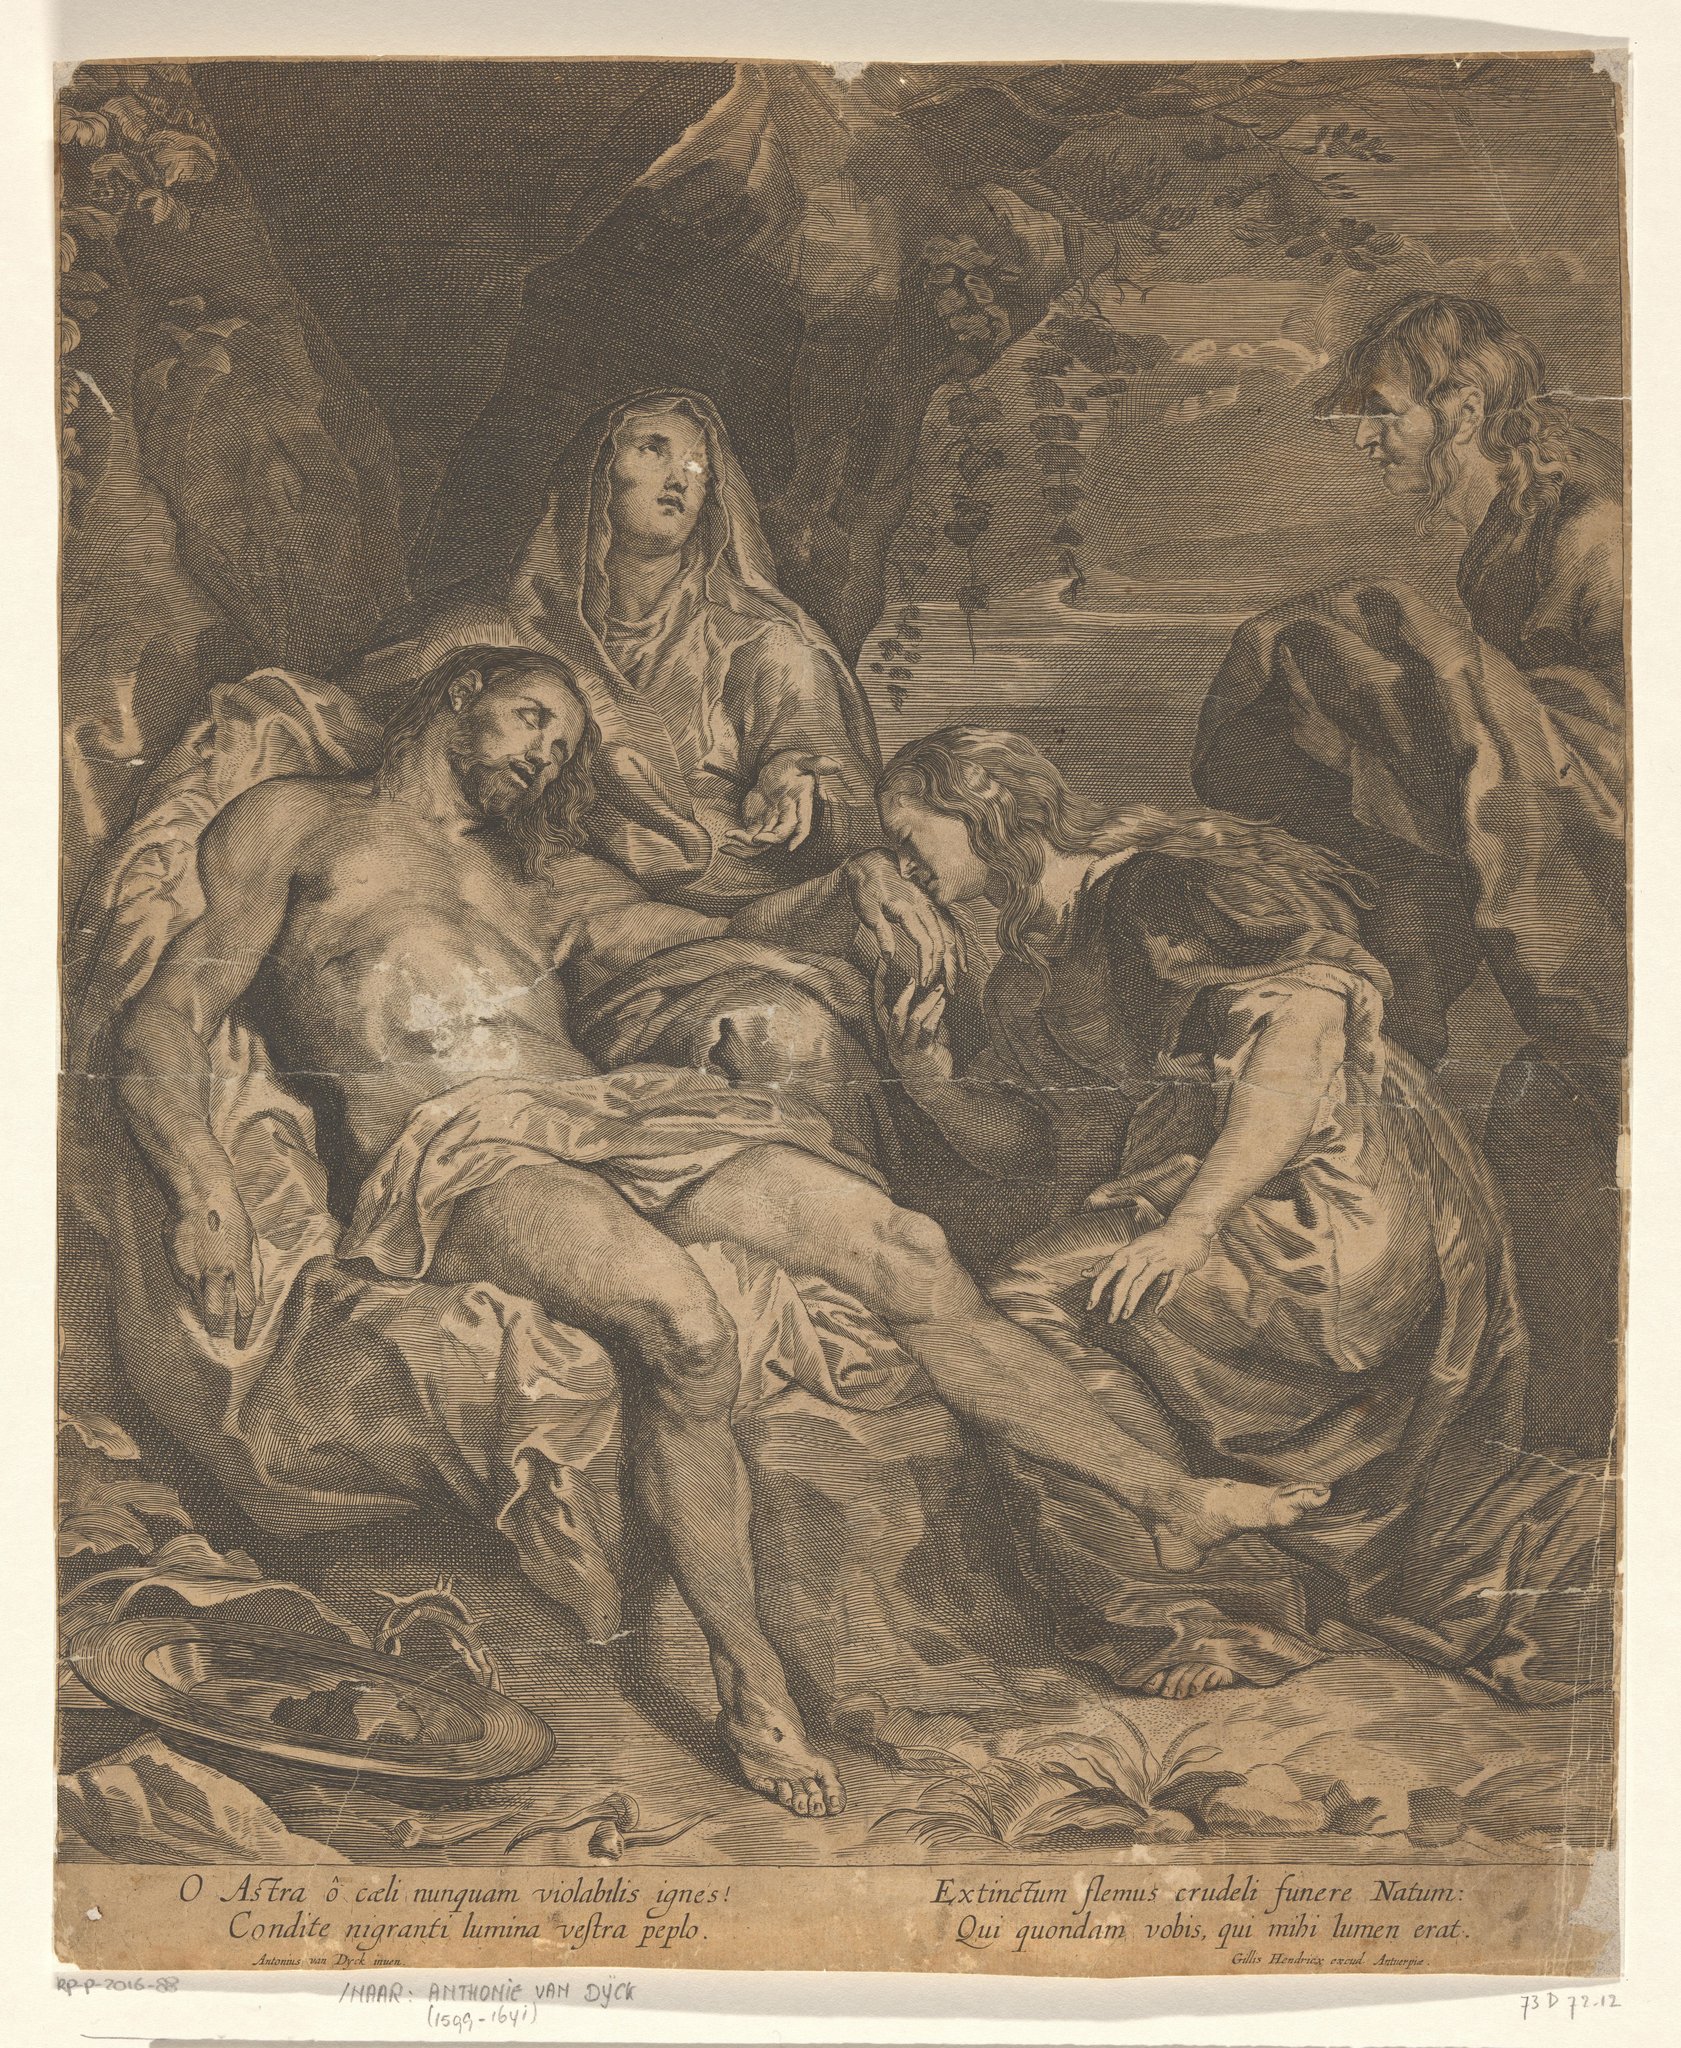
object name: print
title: Bewening van Christus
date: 1615-1691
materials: paper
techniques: engraving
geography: low countries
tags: christ's body supported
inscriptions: collector's mark: Lugt 2228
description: Maria zit onder een boom en kijkt omhoog. Ze ondersteunt het hoofd van Christus wiens lichaam bij haar op een rots ligt. Maria Magdalena kust Christus' linkerhand en Johannes de Evangelist staat achter haar. Linksvoor enkele passiewerktuigen. In de ondermarge vier regels Latijnse tekst.